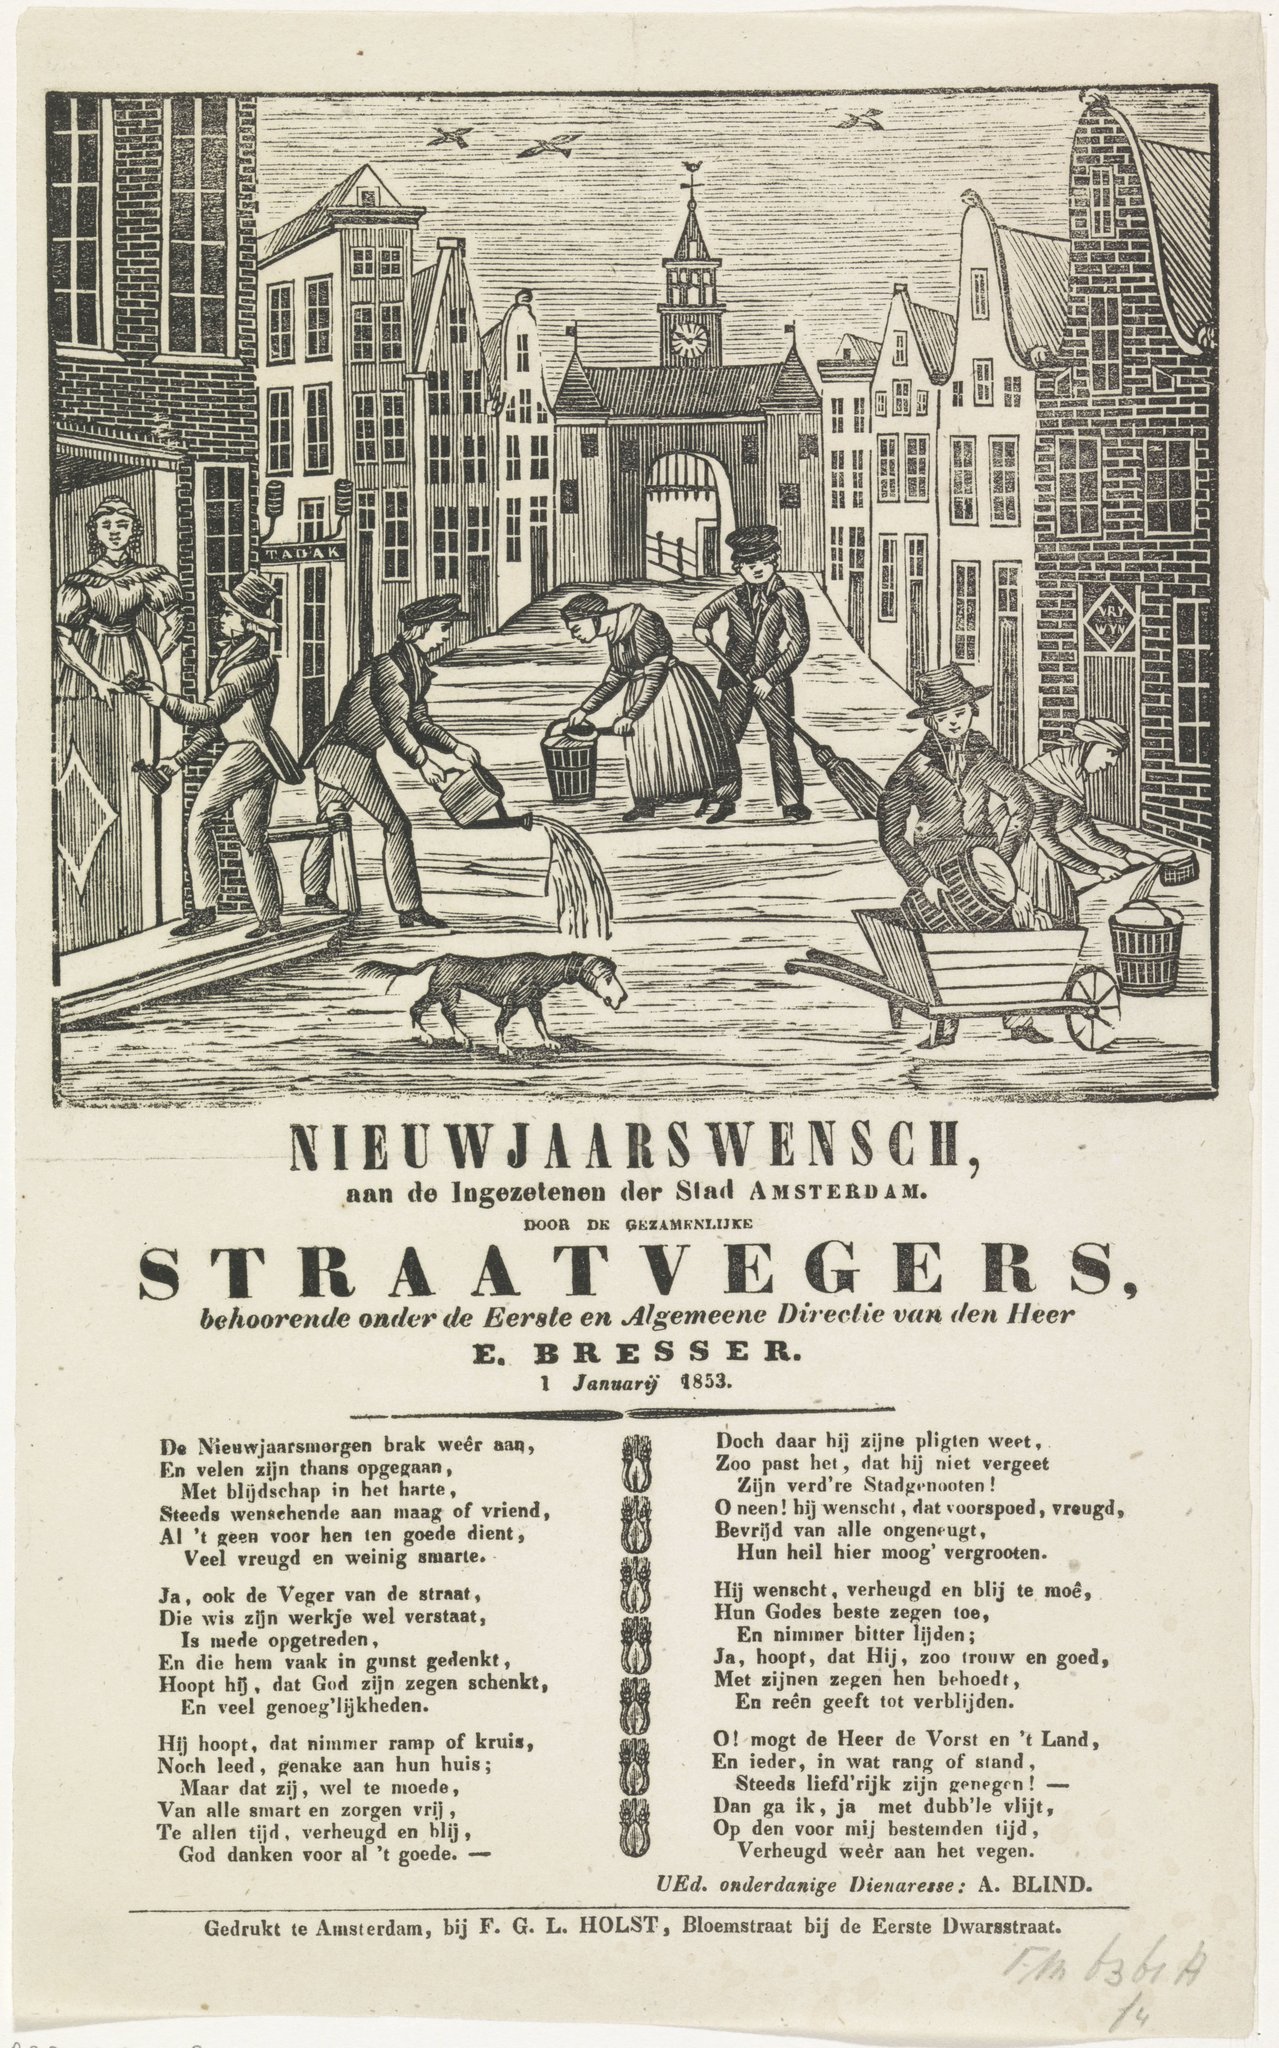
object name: new year card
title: Nieuwjaarswensch (...) door de gezamenlijke Straatvegers, onder de eerste en algemeene directie van den heer E. Bresser (...) 1853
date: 1852-1853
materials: paper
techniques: letterpress printing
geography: amsterdam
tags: street - ii - ideal city, street sweeping, street sweeper, amsterdam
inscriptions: collector's mark: Lugt 2228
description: Nieuwjaarswens van de Amsterdamse straatvegers voor het jaar 1853. Gezicht in de Leidsestraat te Amsterdam met de Leidsepoort, waar meerdere mannelijke en vrouwelijke stratenvegers aan het werk zijn, op de voorgrond haalt een man geld op bij een huis. Met een vers in twee kolommen. Namens de straatveegster: A. Blind.